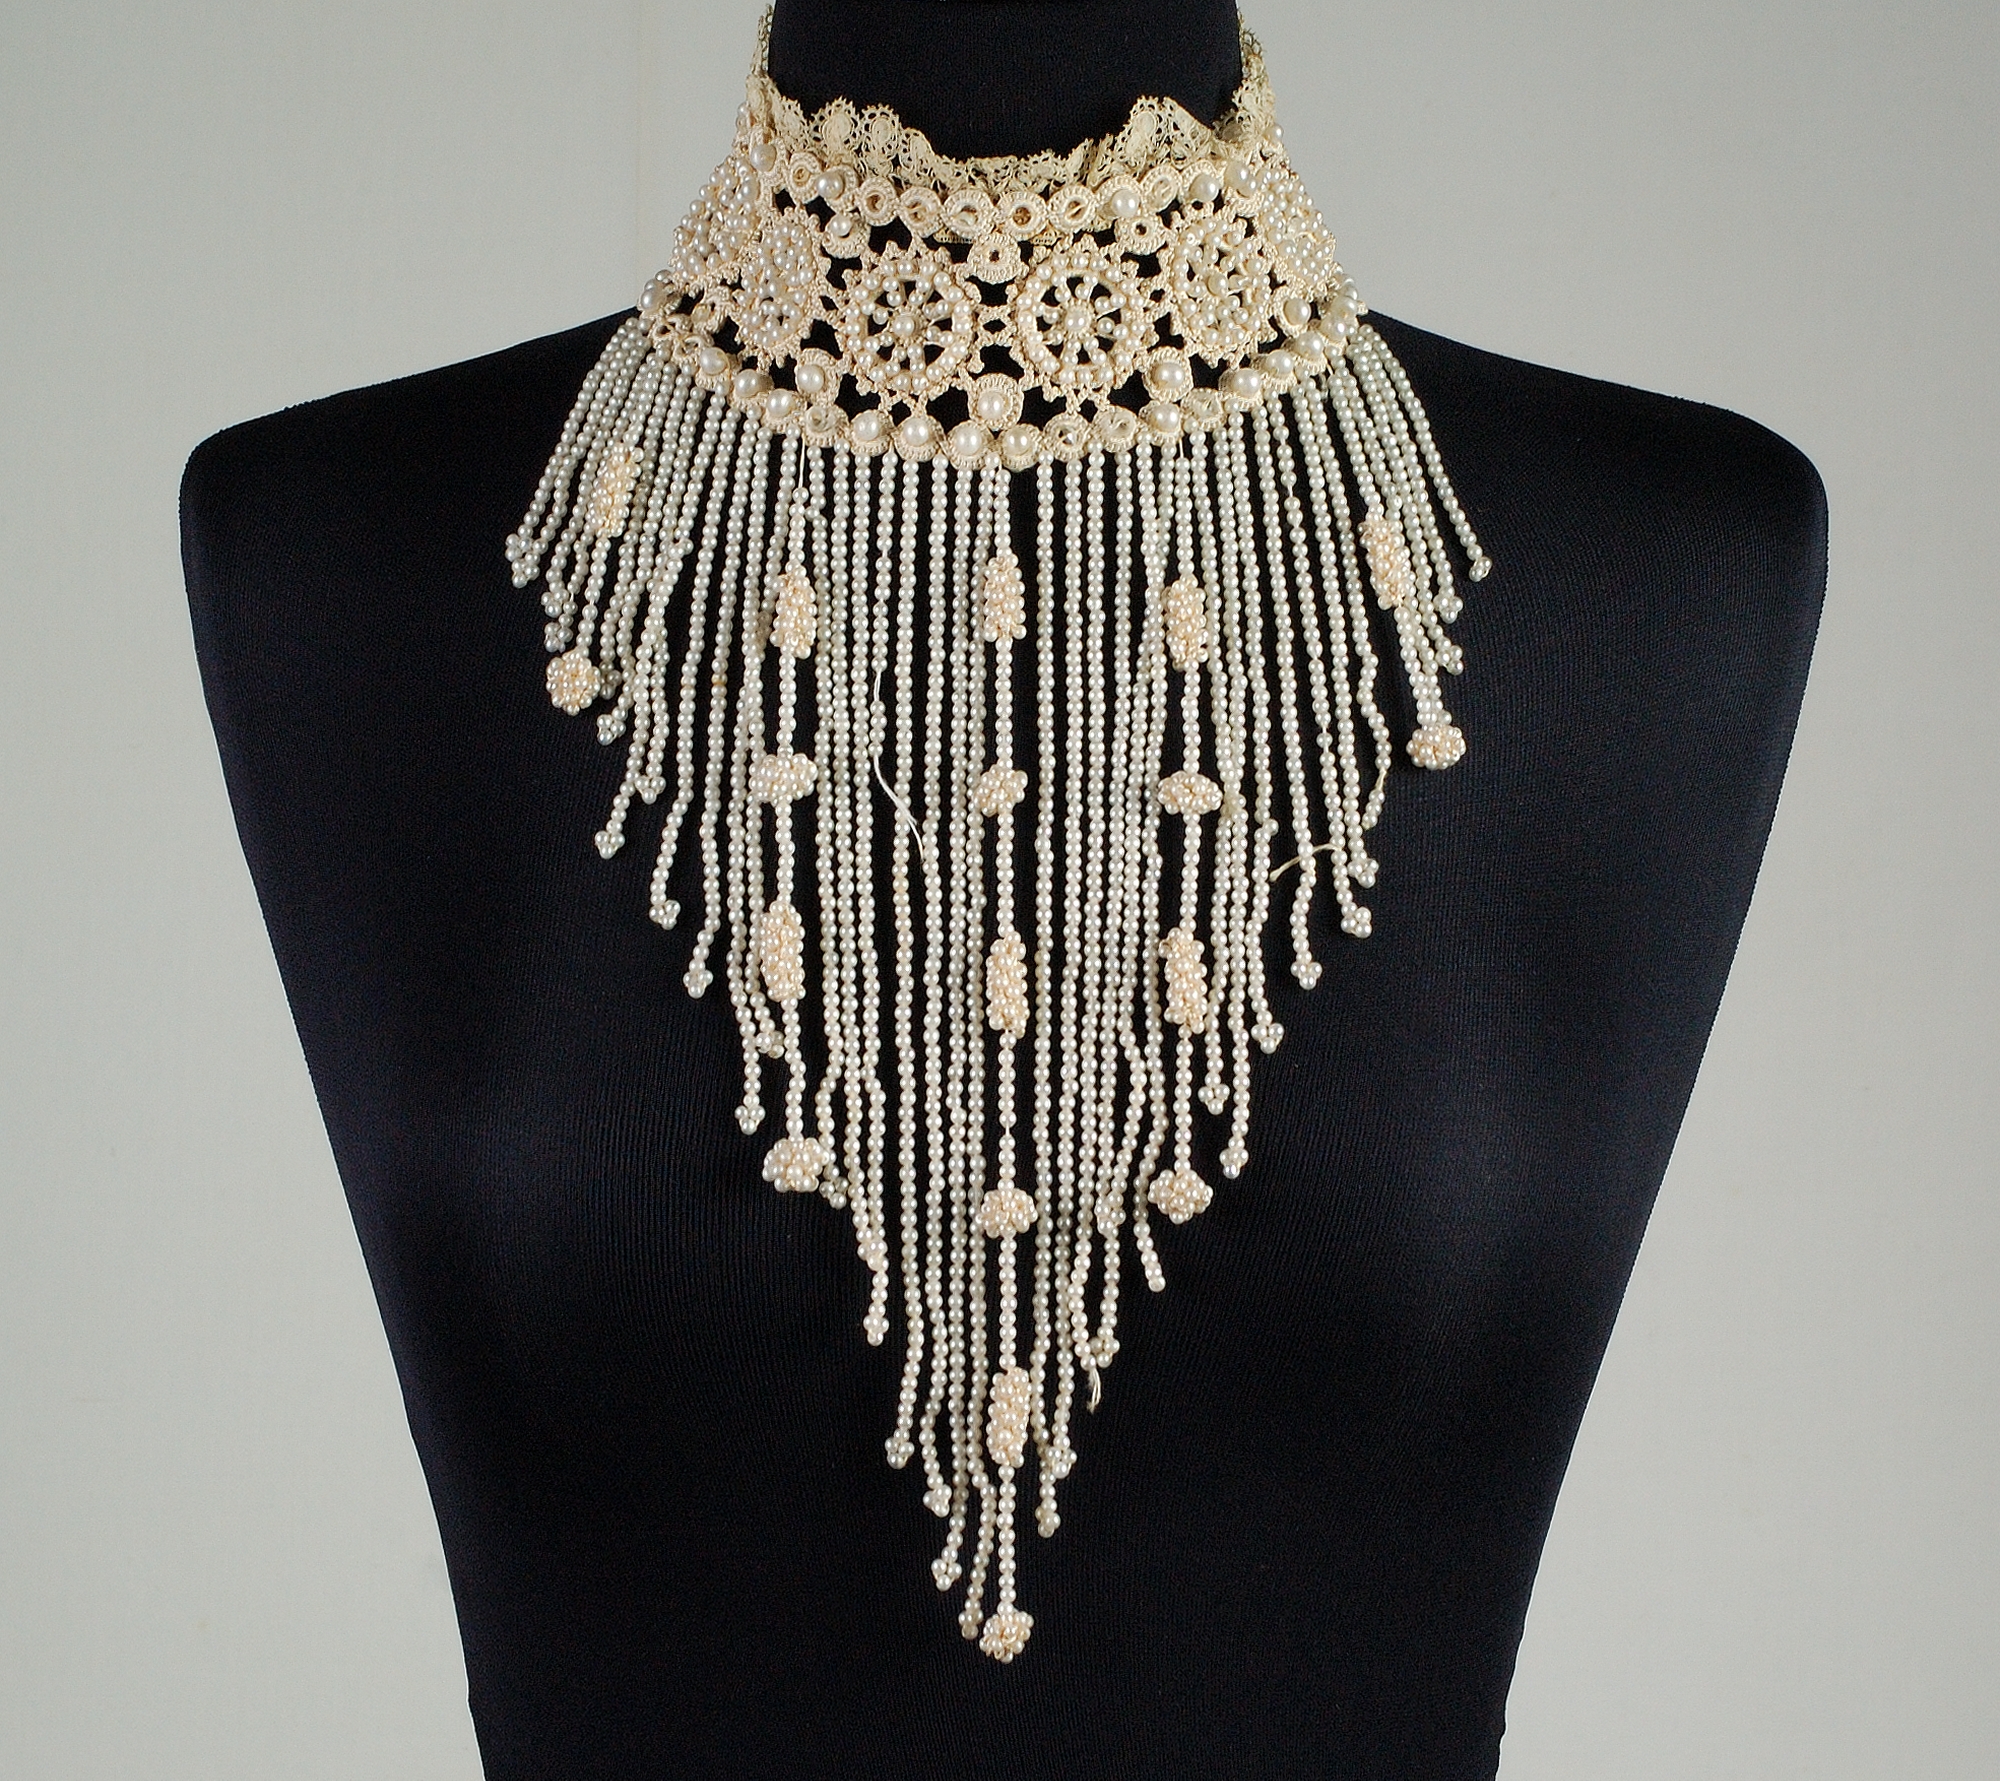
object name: collar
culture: french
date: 1892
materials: linen, silk